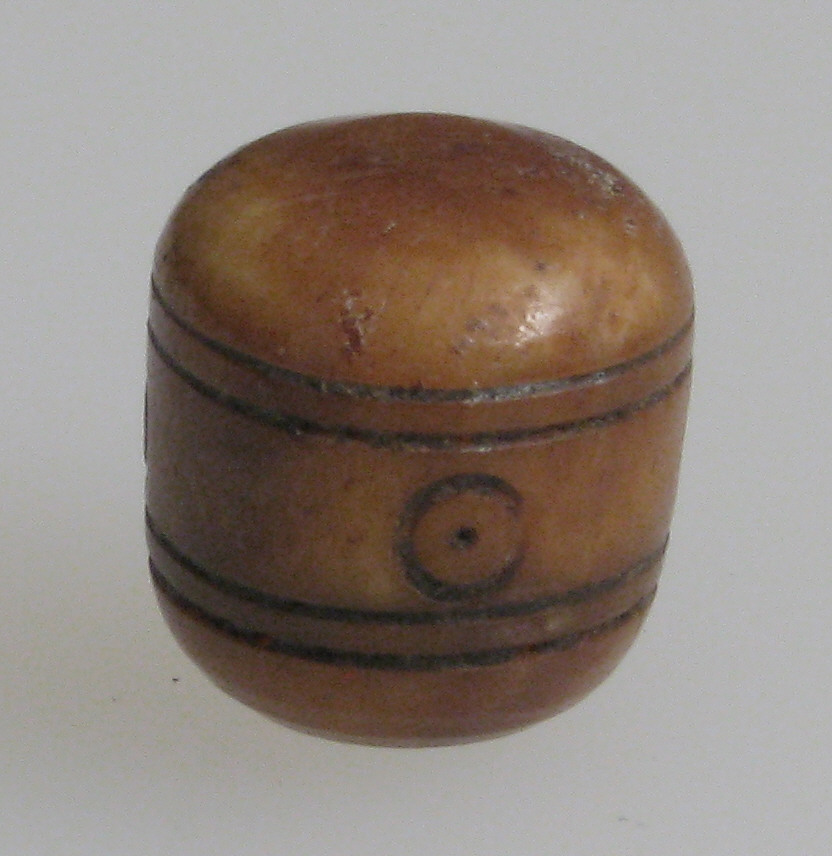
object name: knob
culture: coptic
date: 301-400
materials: bone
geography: egypt